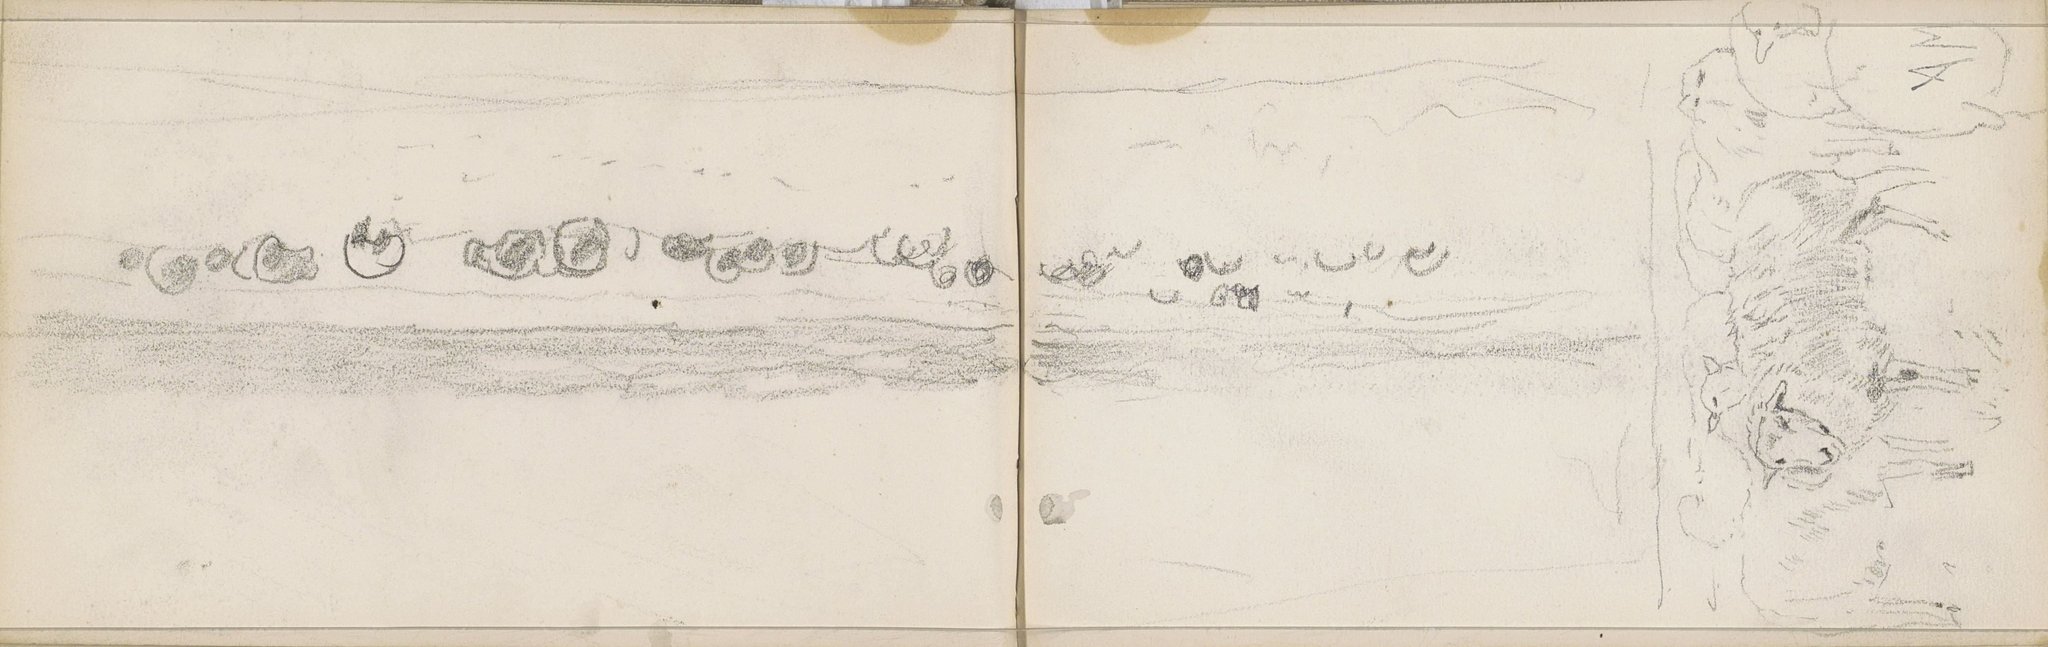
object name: sketchbook leaf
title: Landschap met grazende schapen en een schaapskudde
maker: anton mauve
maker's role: draughtsman, painter, print maker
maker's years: 1838-1888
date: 1848-1888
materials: paper, pencil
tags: landscapes, sheep, herd, flock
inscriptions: monogram: ‘AM’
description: Blad 28 verso en 29 recto uit een schetsboek met 44 bladen.